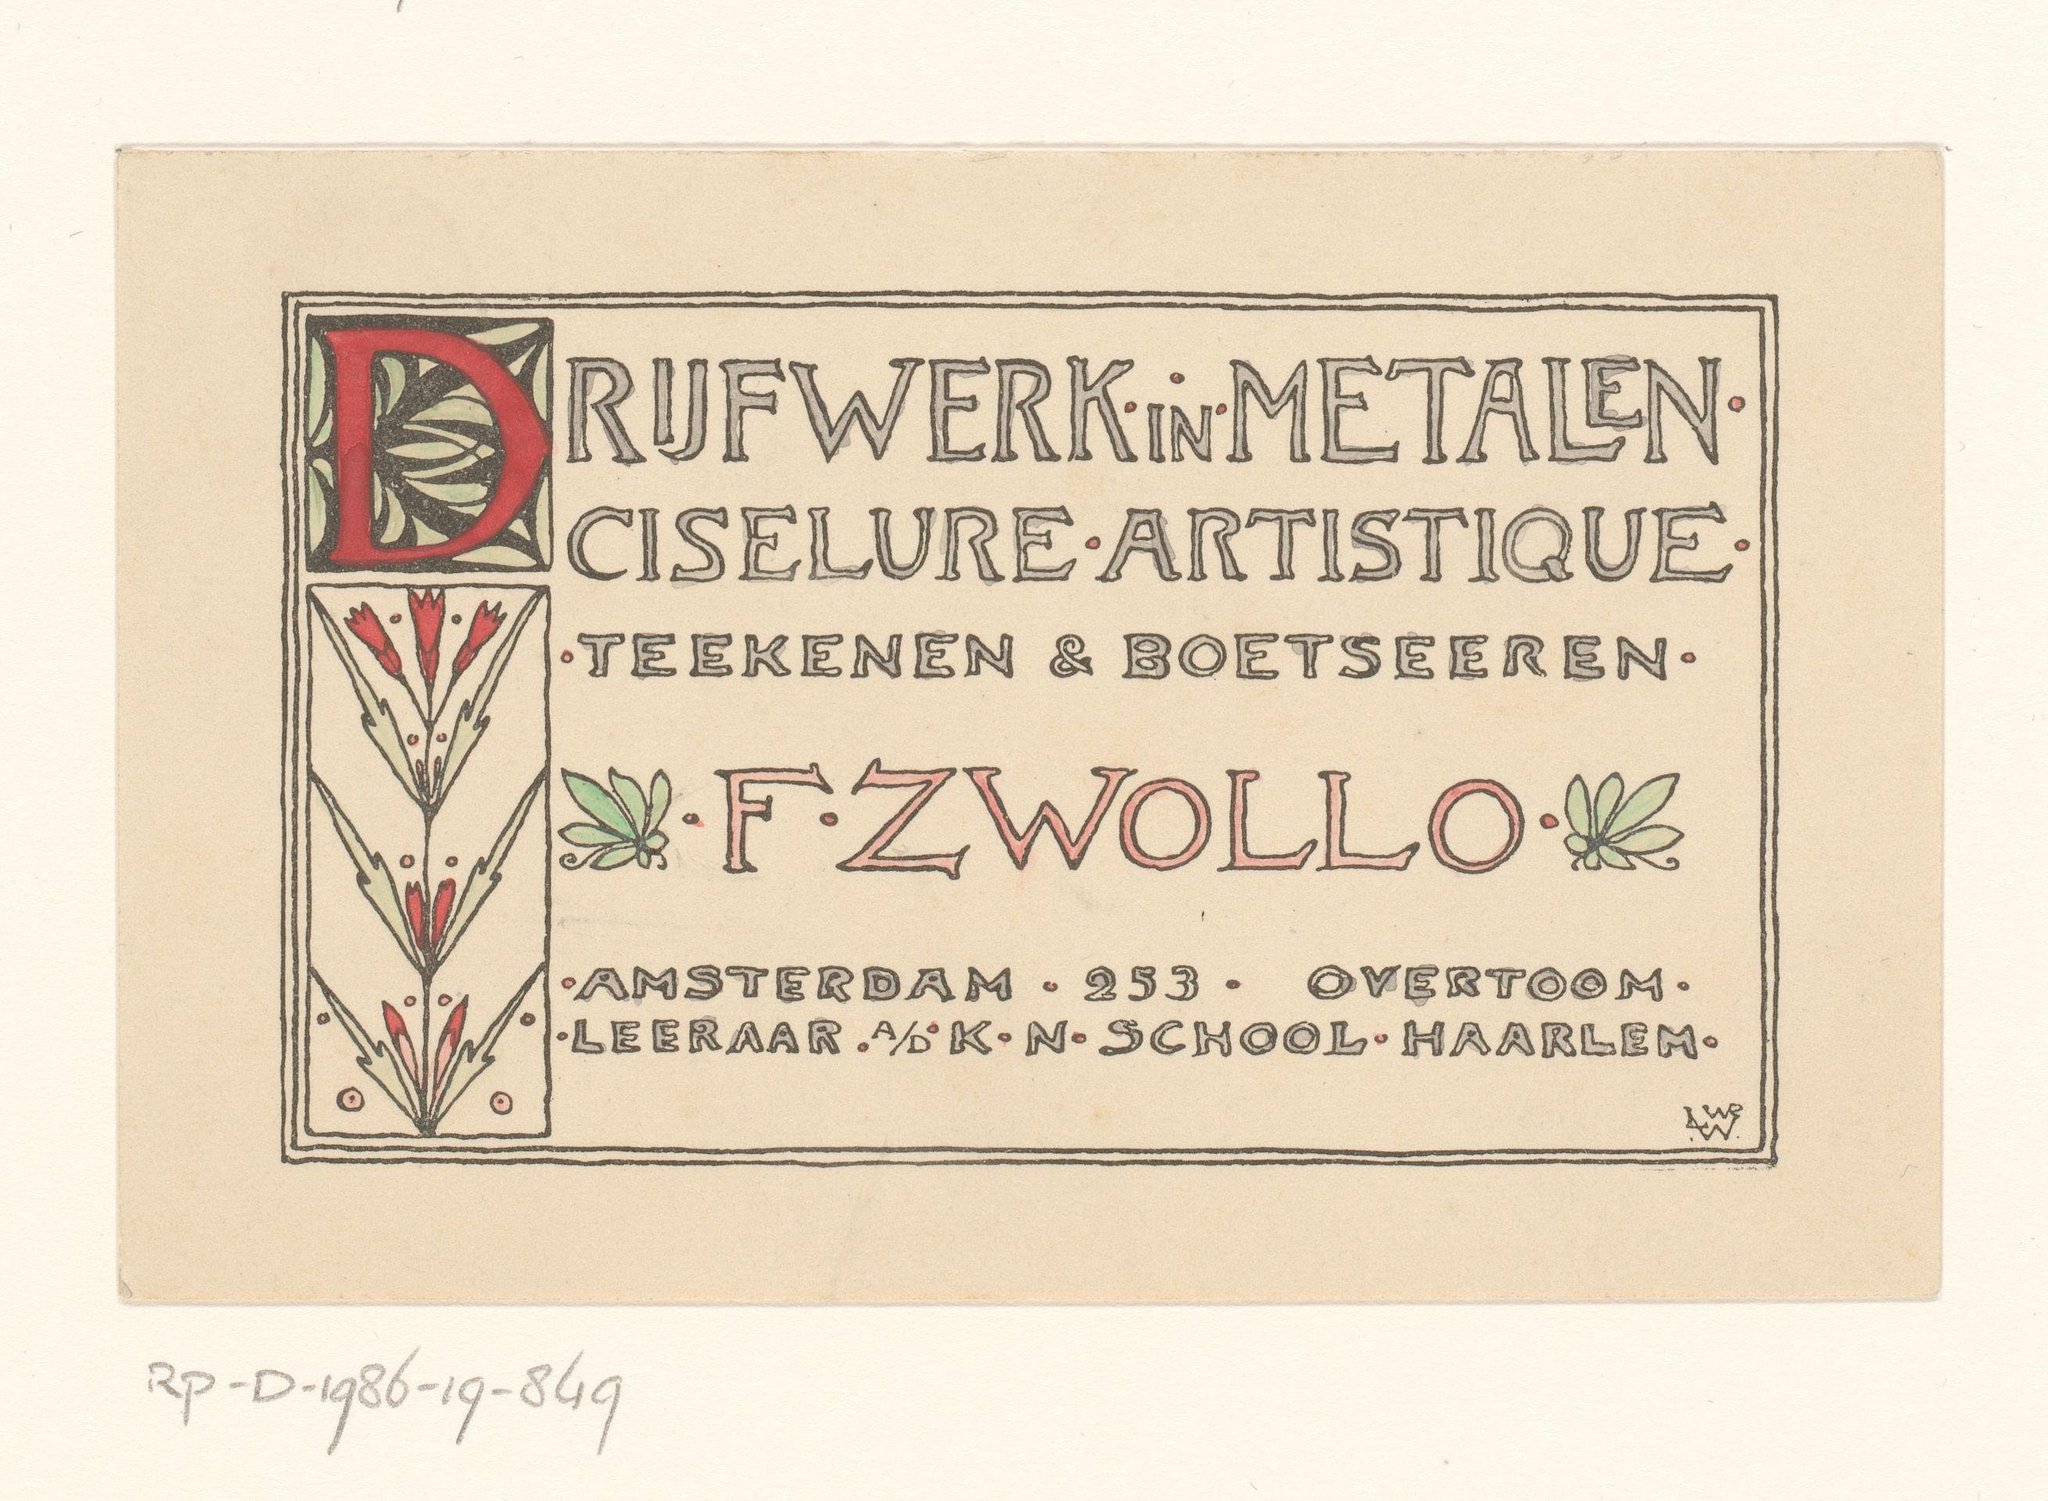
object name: photomechanical print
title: Adreskaart van F. Zwollo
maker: willem wenckebach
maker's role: designer, draughtsman, painter, print maker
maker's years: 1860-1937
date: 1900-1910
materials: paper, watercolor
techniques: brush, printing block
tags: amsterdam, silversmith, frans zwollo (i), flowers ~ ornament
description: Tekst in kader met versierde initiaal 'D' en bloemmotieven.